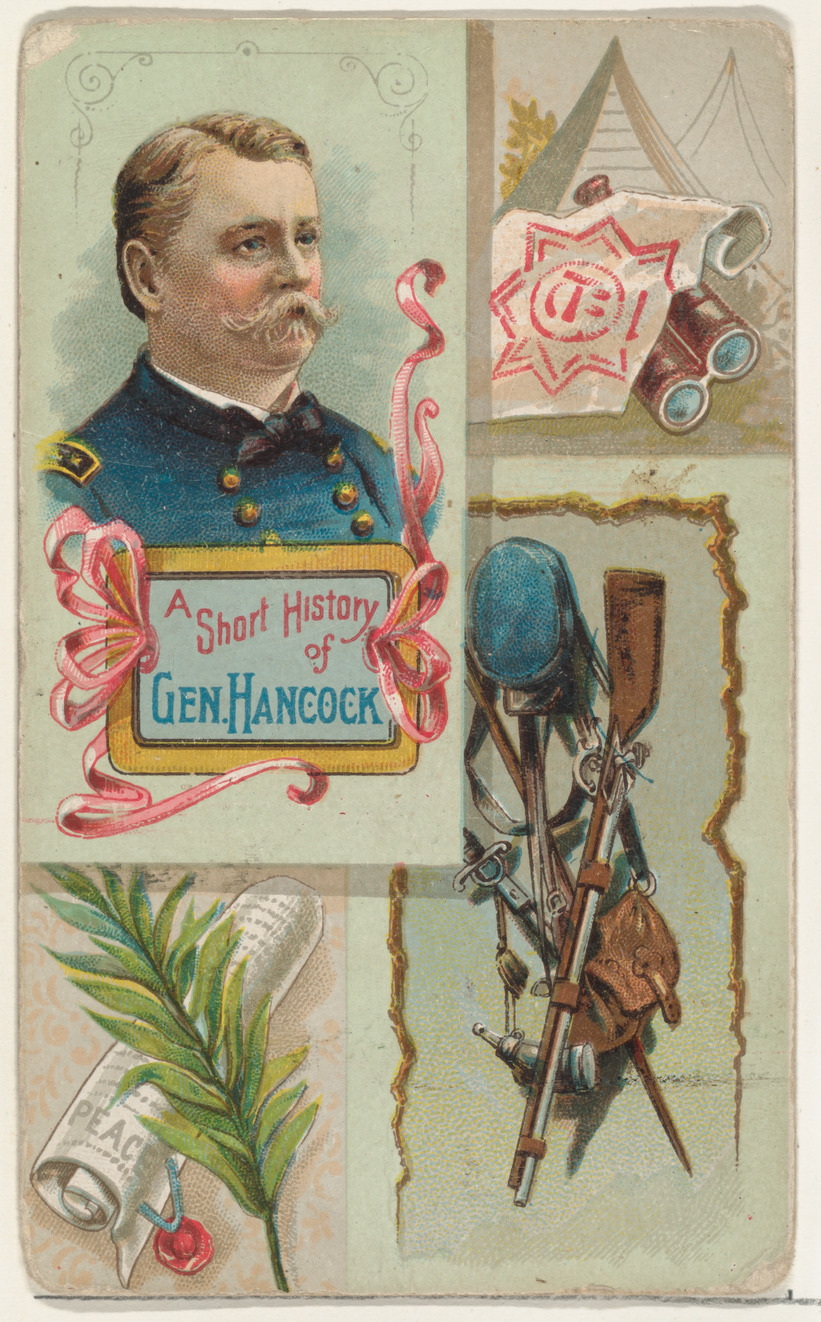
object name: print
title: A Short History: General Winfield S. Hancock, from the Histories of Generals series (N114) issued by W. Duke, Sons & Co. to promote Honest Long Cut Smoking and Chewing Tobacco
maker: w. duke, sons & co.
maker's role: publisher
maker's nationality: american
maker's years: 1870-1920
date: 1888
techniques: color lithograph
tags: firearms,men,profiles,generals